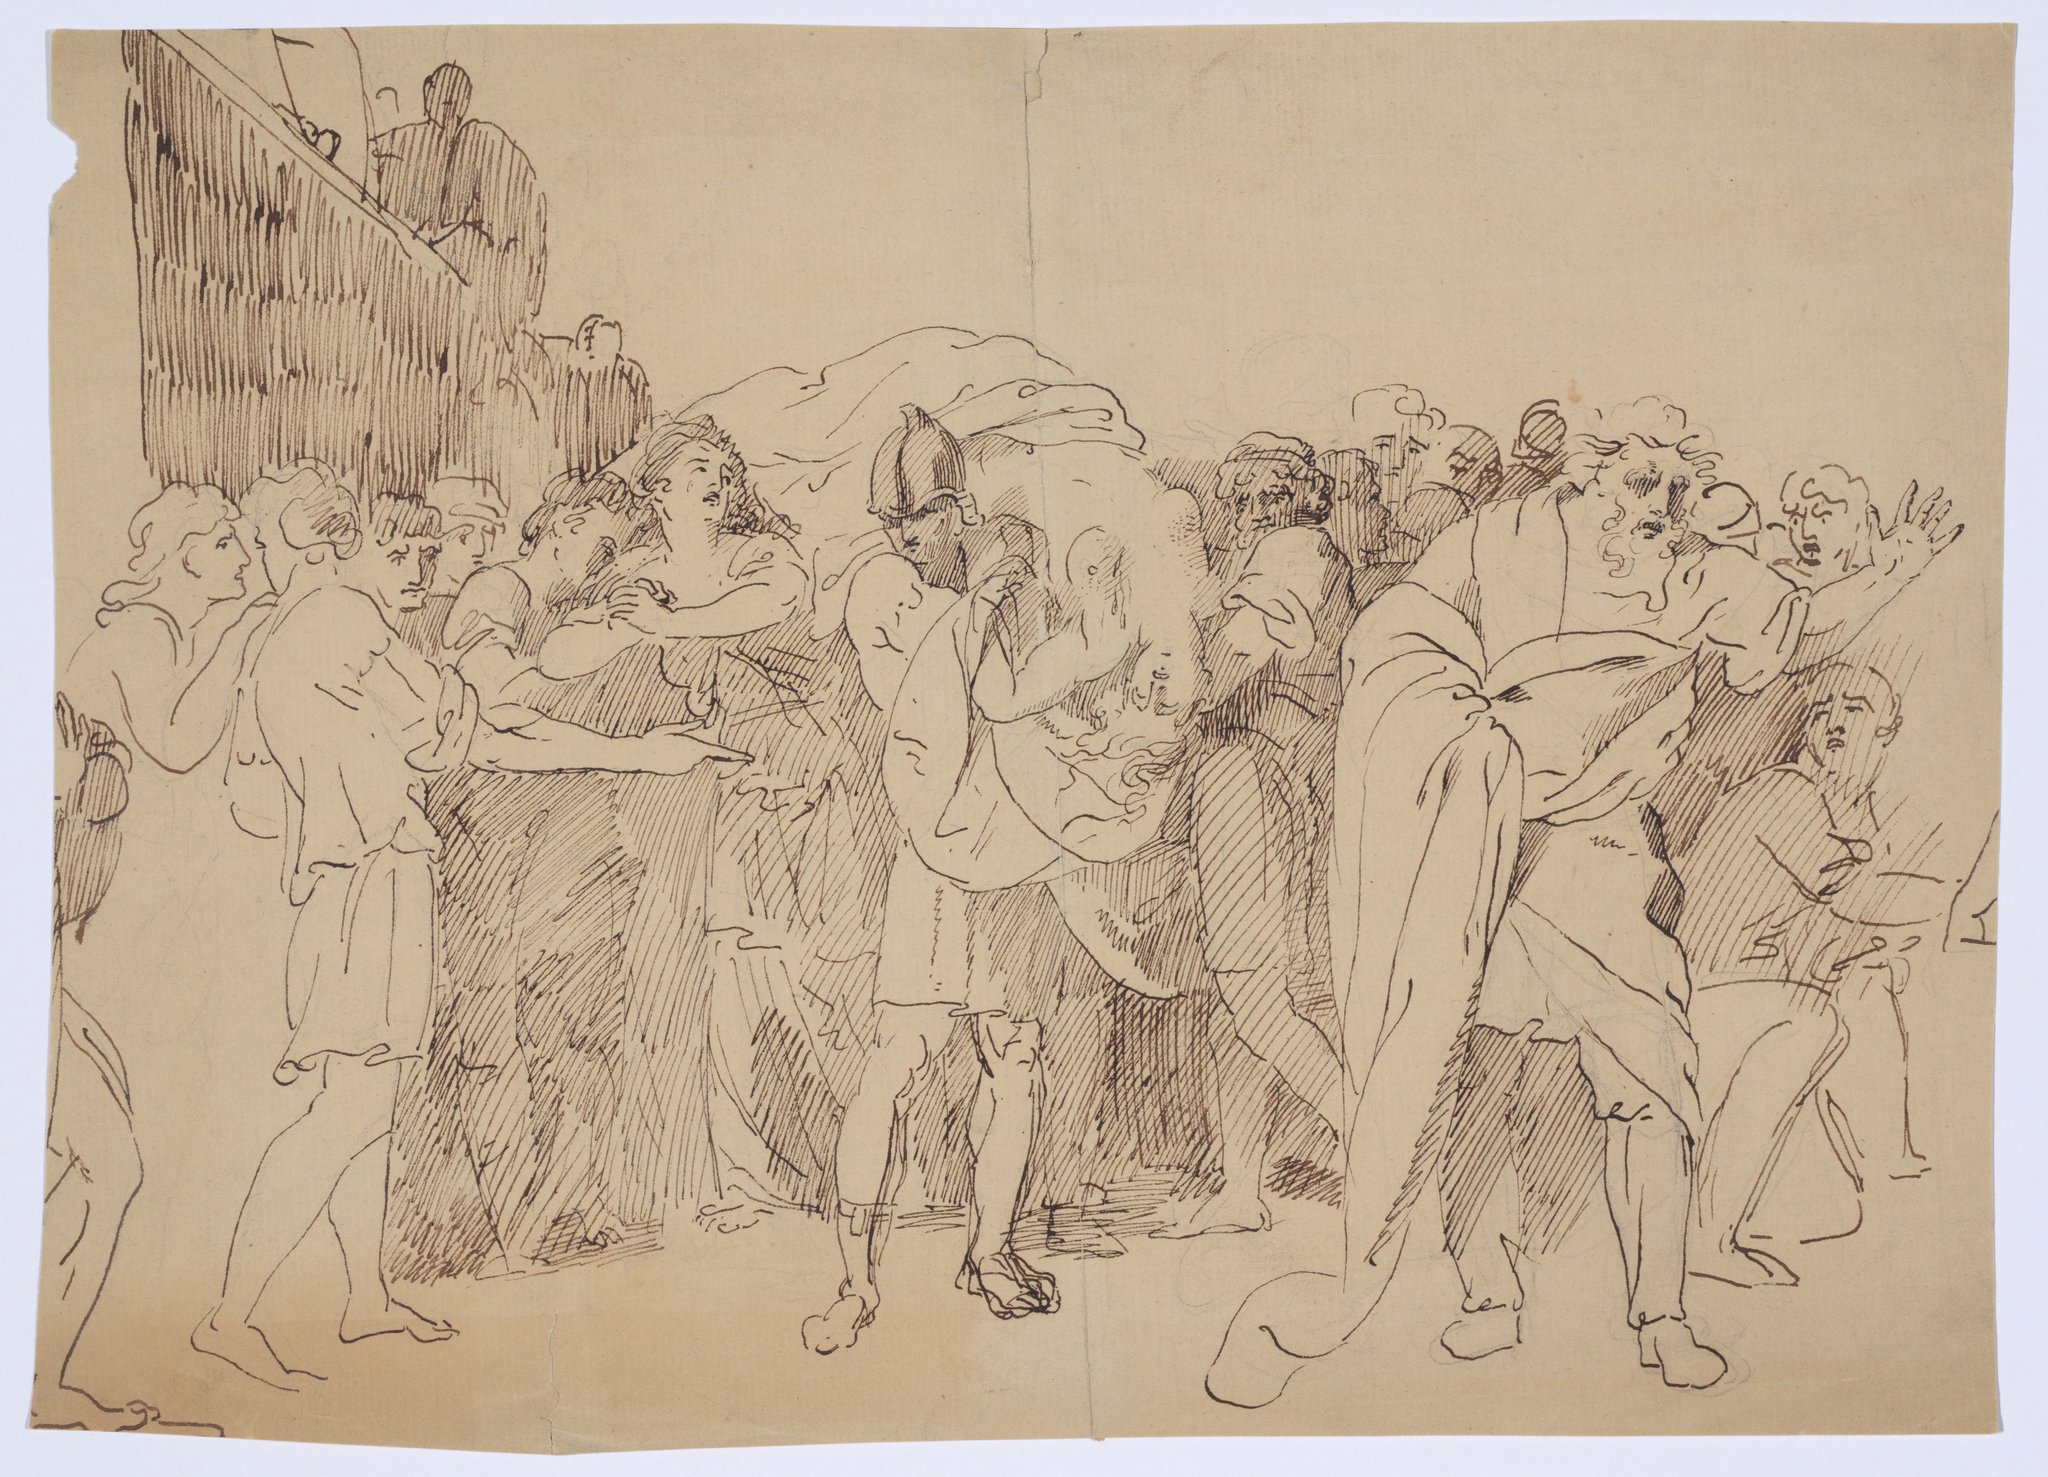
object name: drawing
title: Lucretia's Dead Body is Carried by her Husband, Led by her Mourning Father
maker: john hamilton mortimer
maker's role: artist and publisher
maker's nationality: british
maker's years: 1740-1779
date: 1770-1779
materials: chalk, graphite, ink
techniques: pen